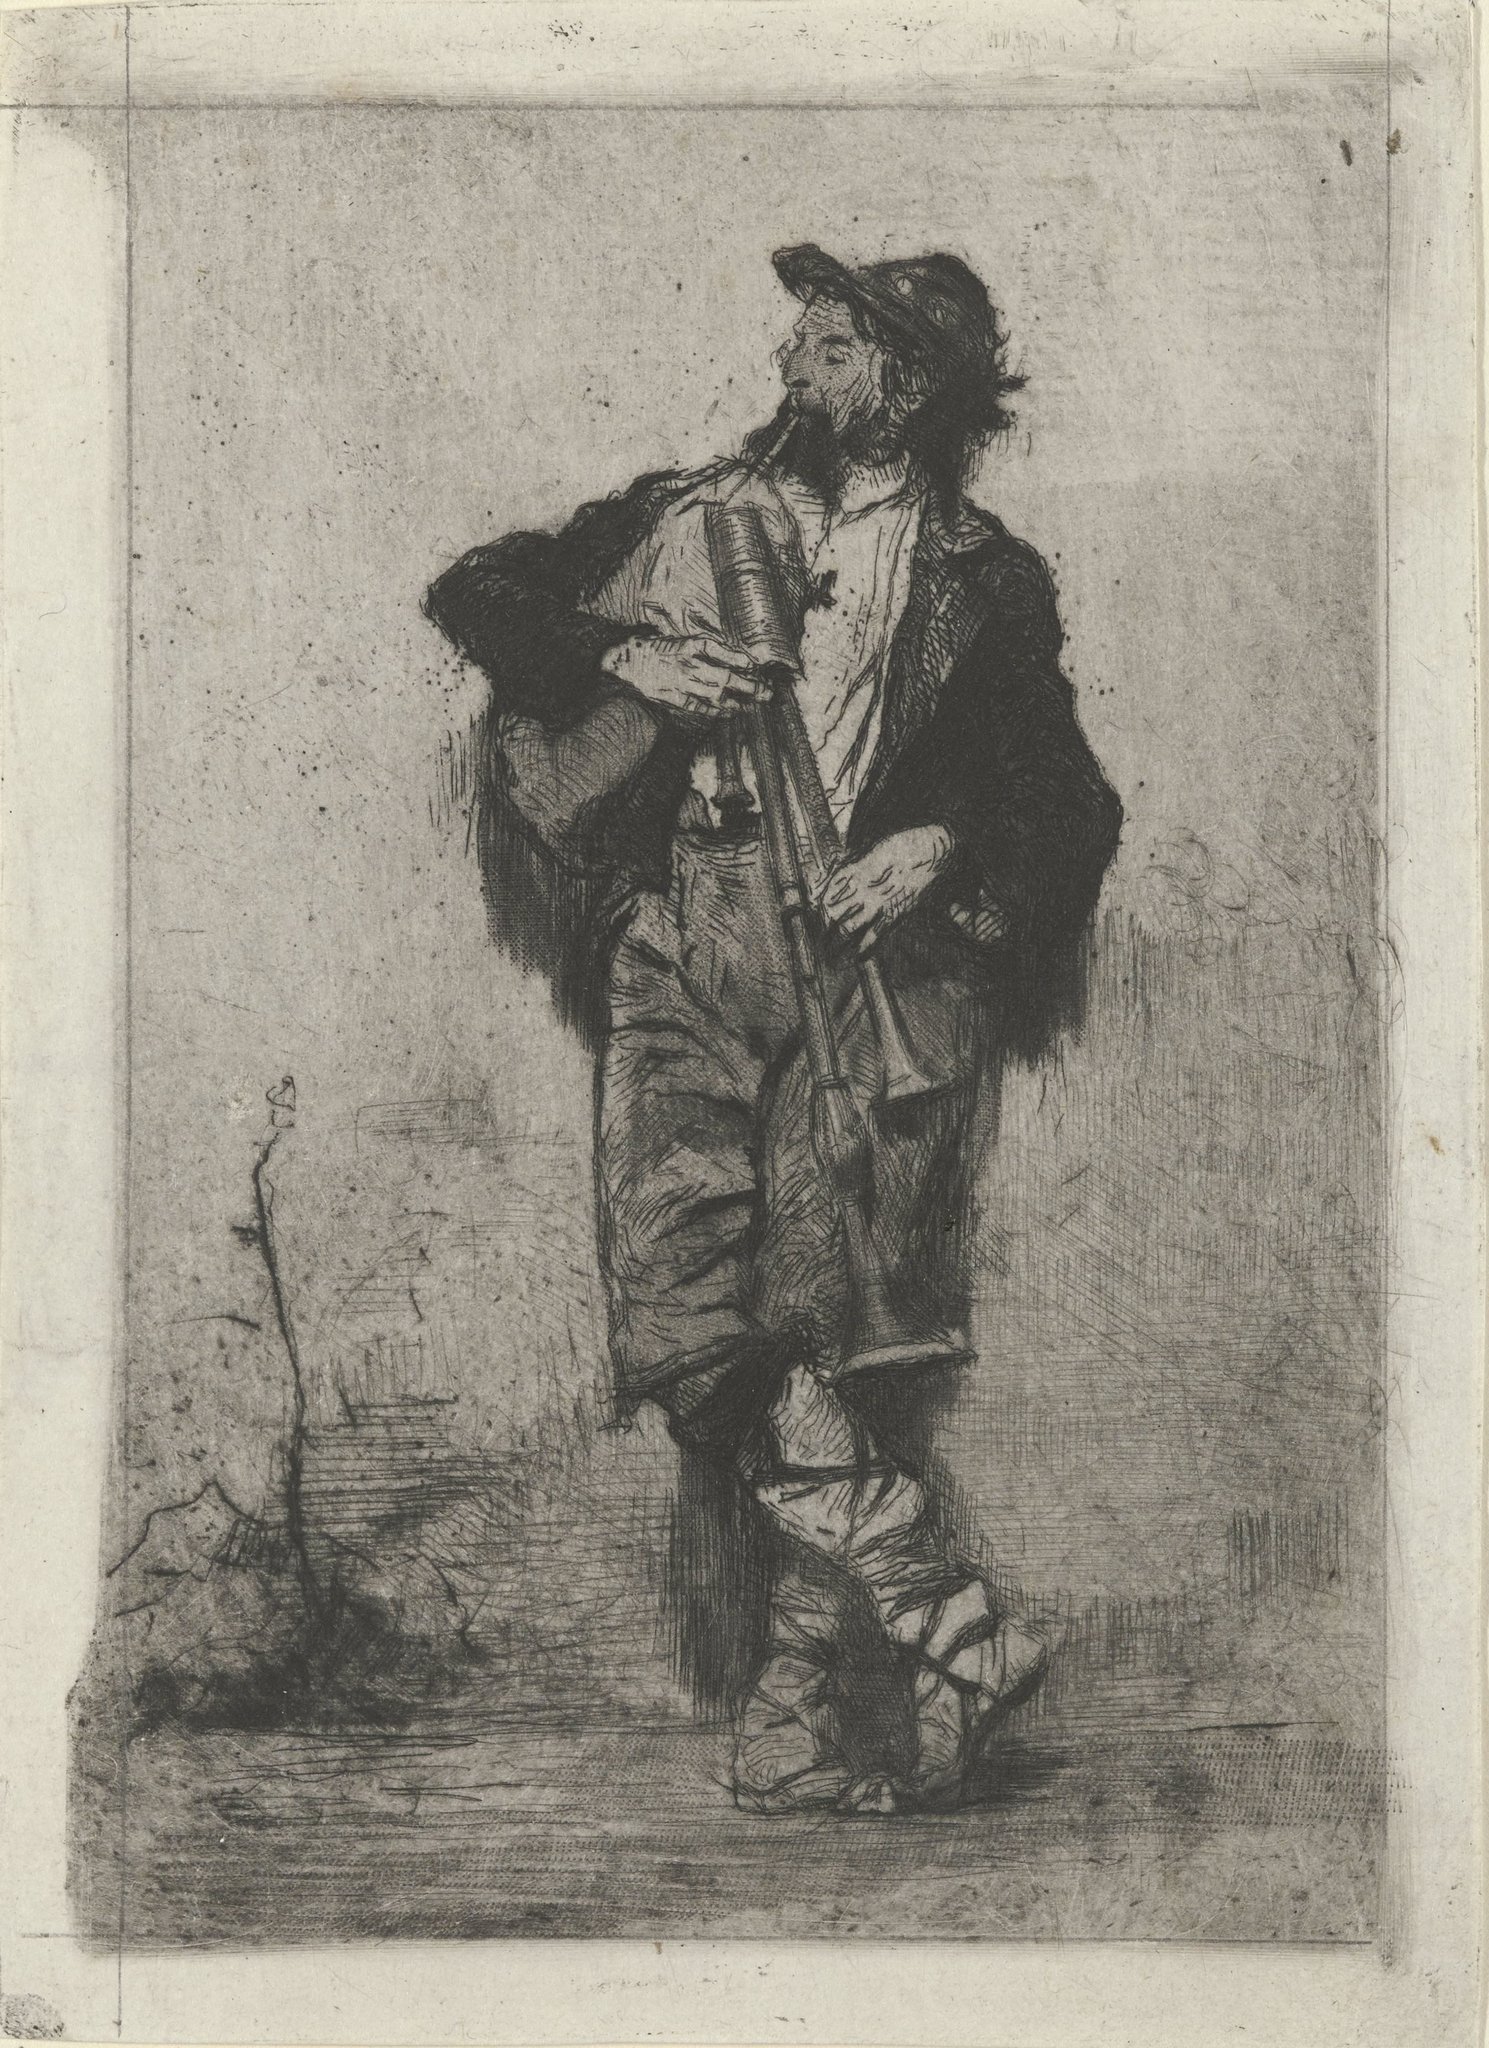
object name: print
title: Doedelzakspeler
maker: mosè di giosuè bianchi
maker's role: draughtsman, print maker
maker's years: 1845-1904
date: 1855-1904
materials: paper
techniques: aquatint, etching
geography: italy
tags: one person playing wind instrument, bagpipe, musette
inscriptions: collector's mark: Lugt 2760, collector's mark: Lugt 2228